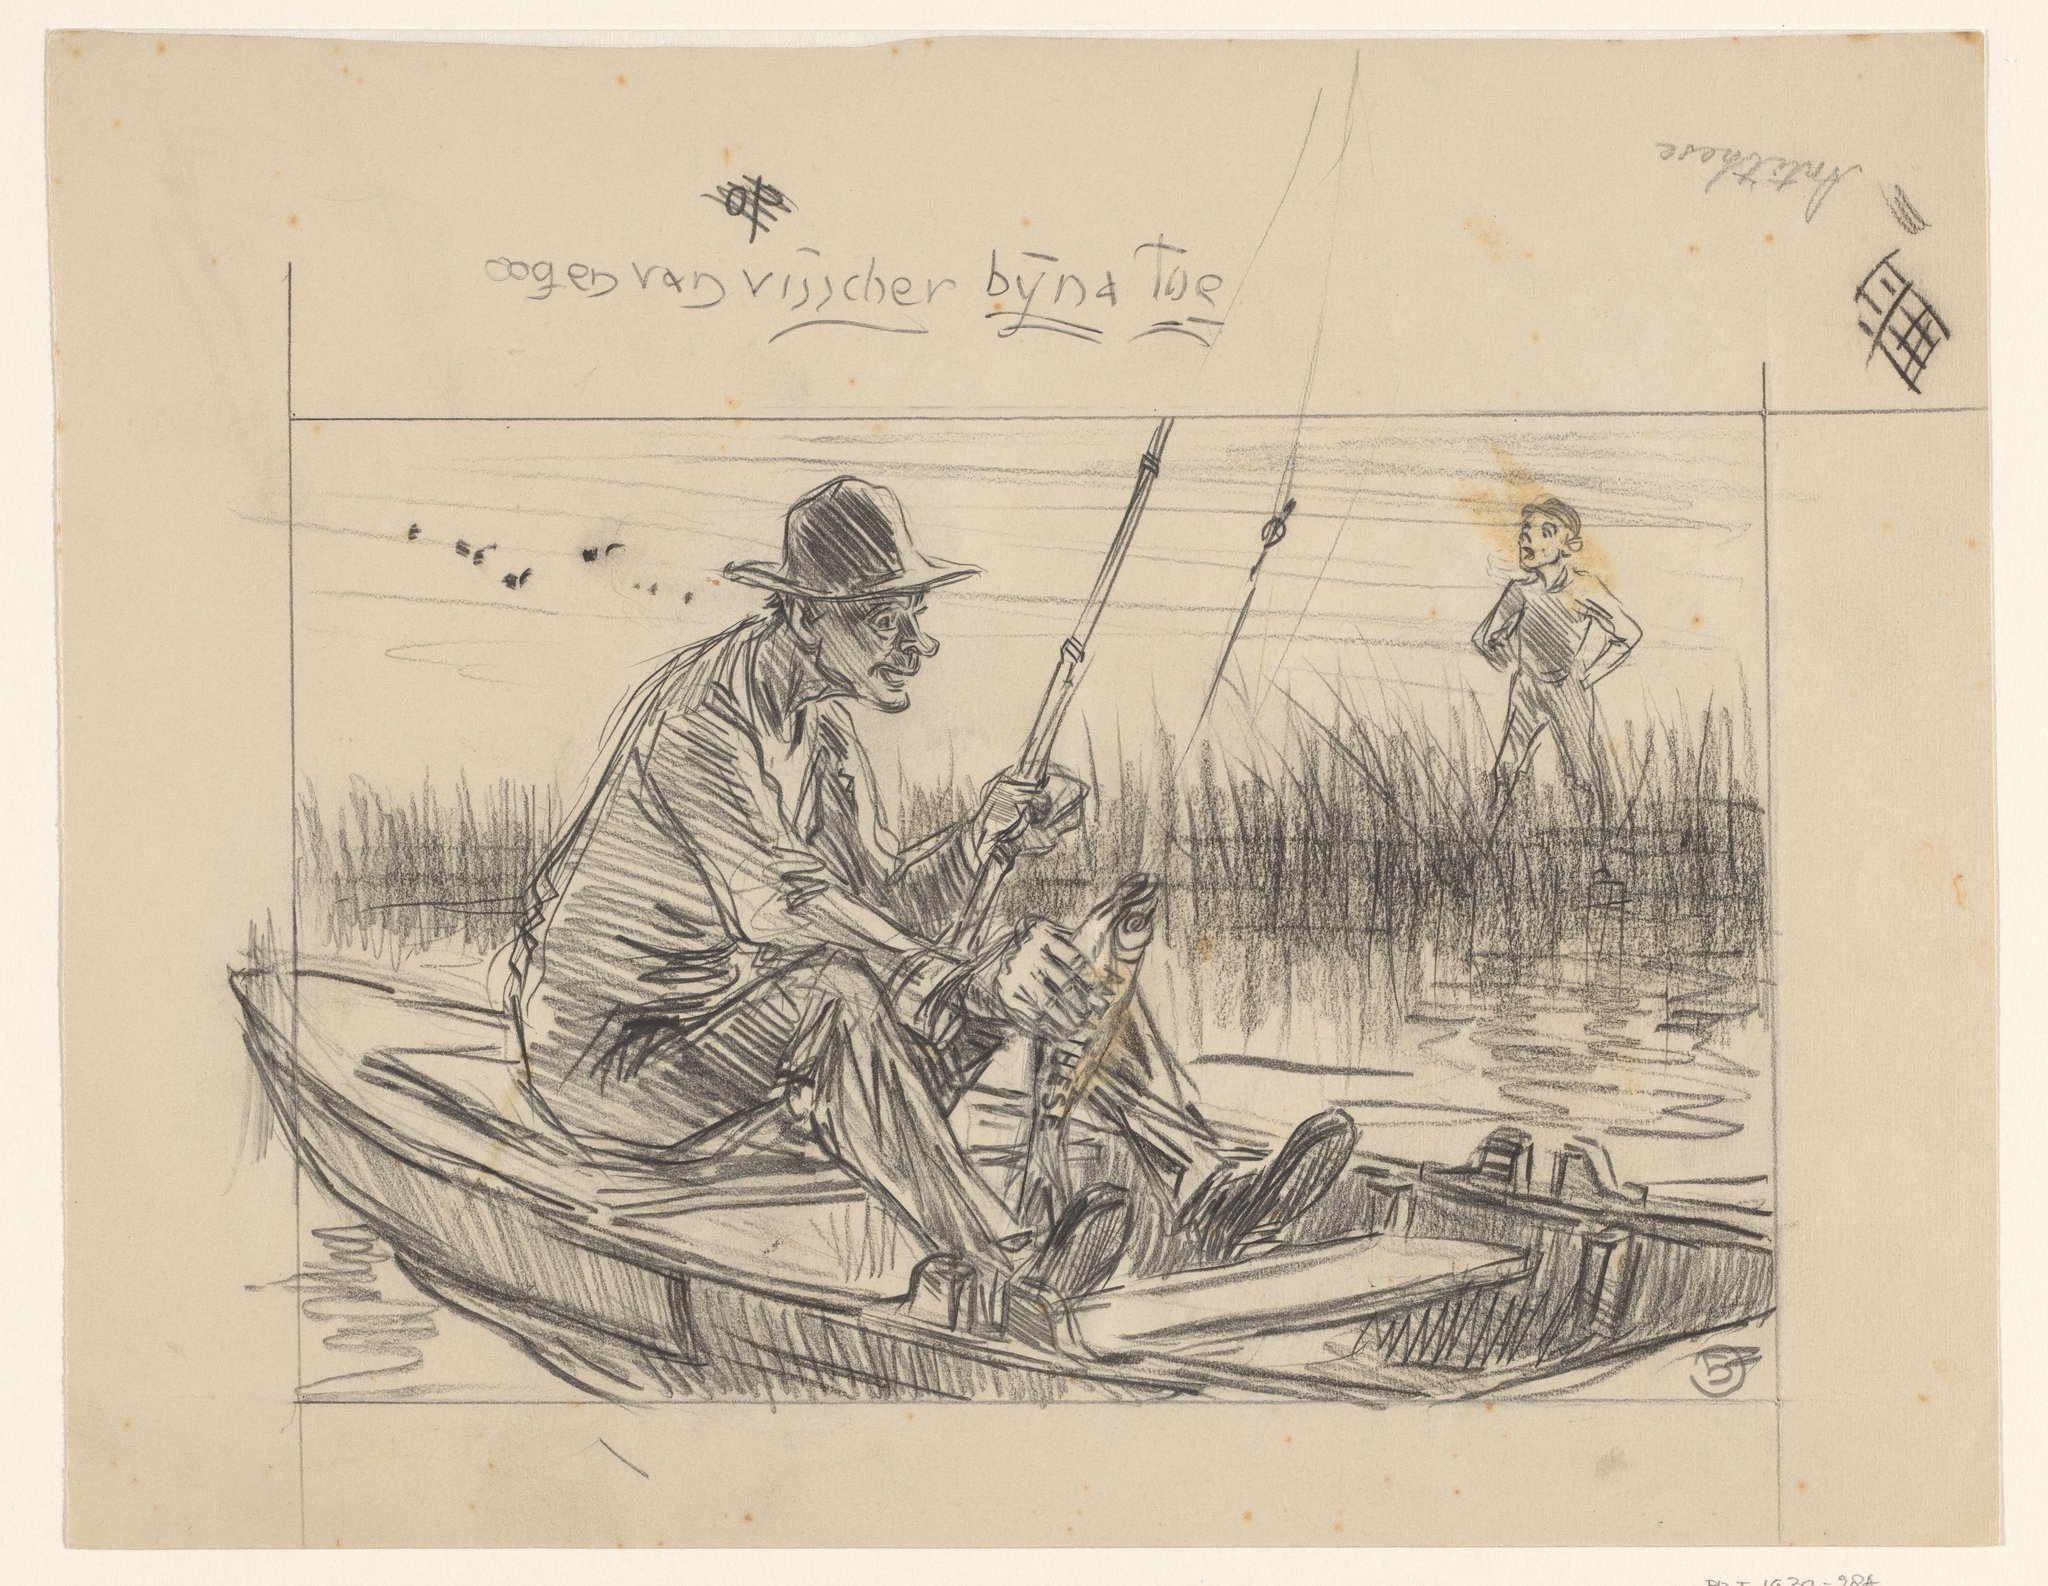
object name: drawing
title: Ontwerp voor een spotprent met een Leidse visser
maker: henricus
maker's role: draughtsman, print maker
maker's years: 1867-1921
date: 1906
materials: chalk, paper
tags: fishes, fisherman, political caricatures and satires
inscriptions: collector's mark: Lugt 2228a, inscription: ‘Antithese’, inscription: ‘oogen van visscher bijna toe’, number: ‘5’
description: Een Leidse visser zit in een boot op een rivier en houdt een vis vast waarop het woord 'antithese' staat. In de achtergrond staat een jongen met de handen in de zakken aan de waterkant.